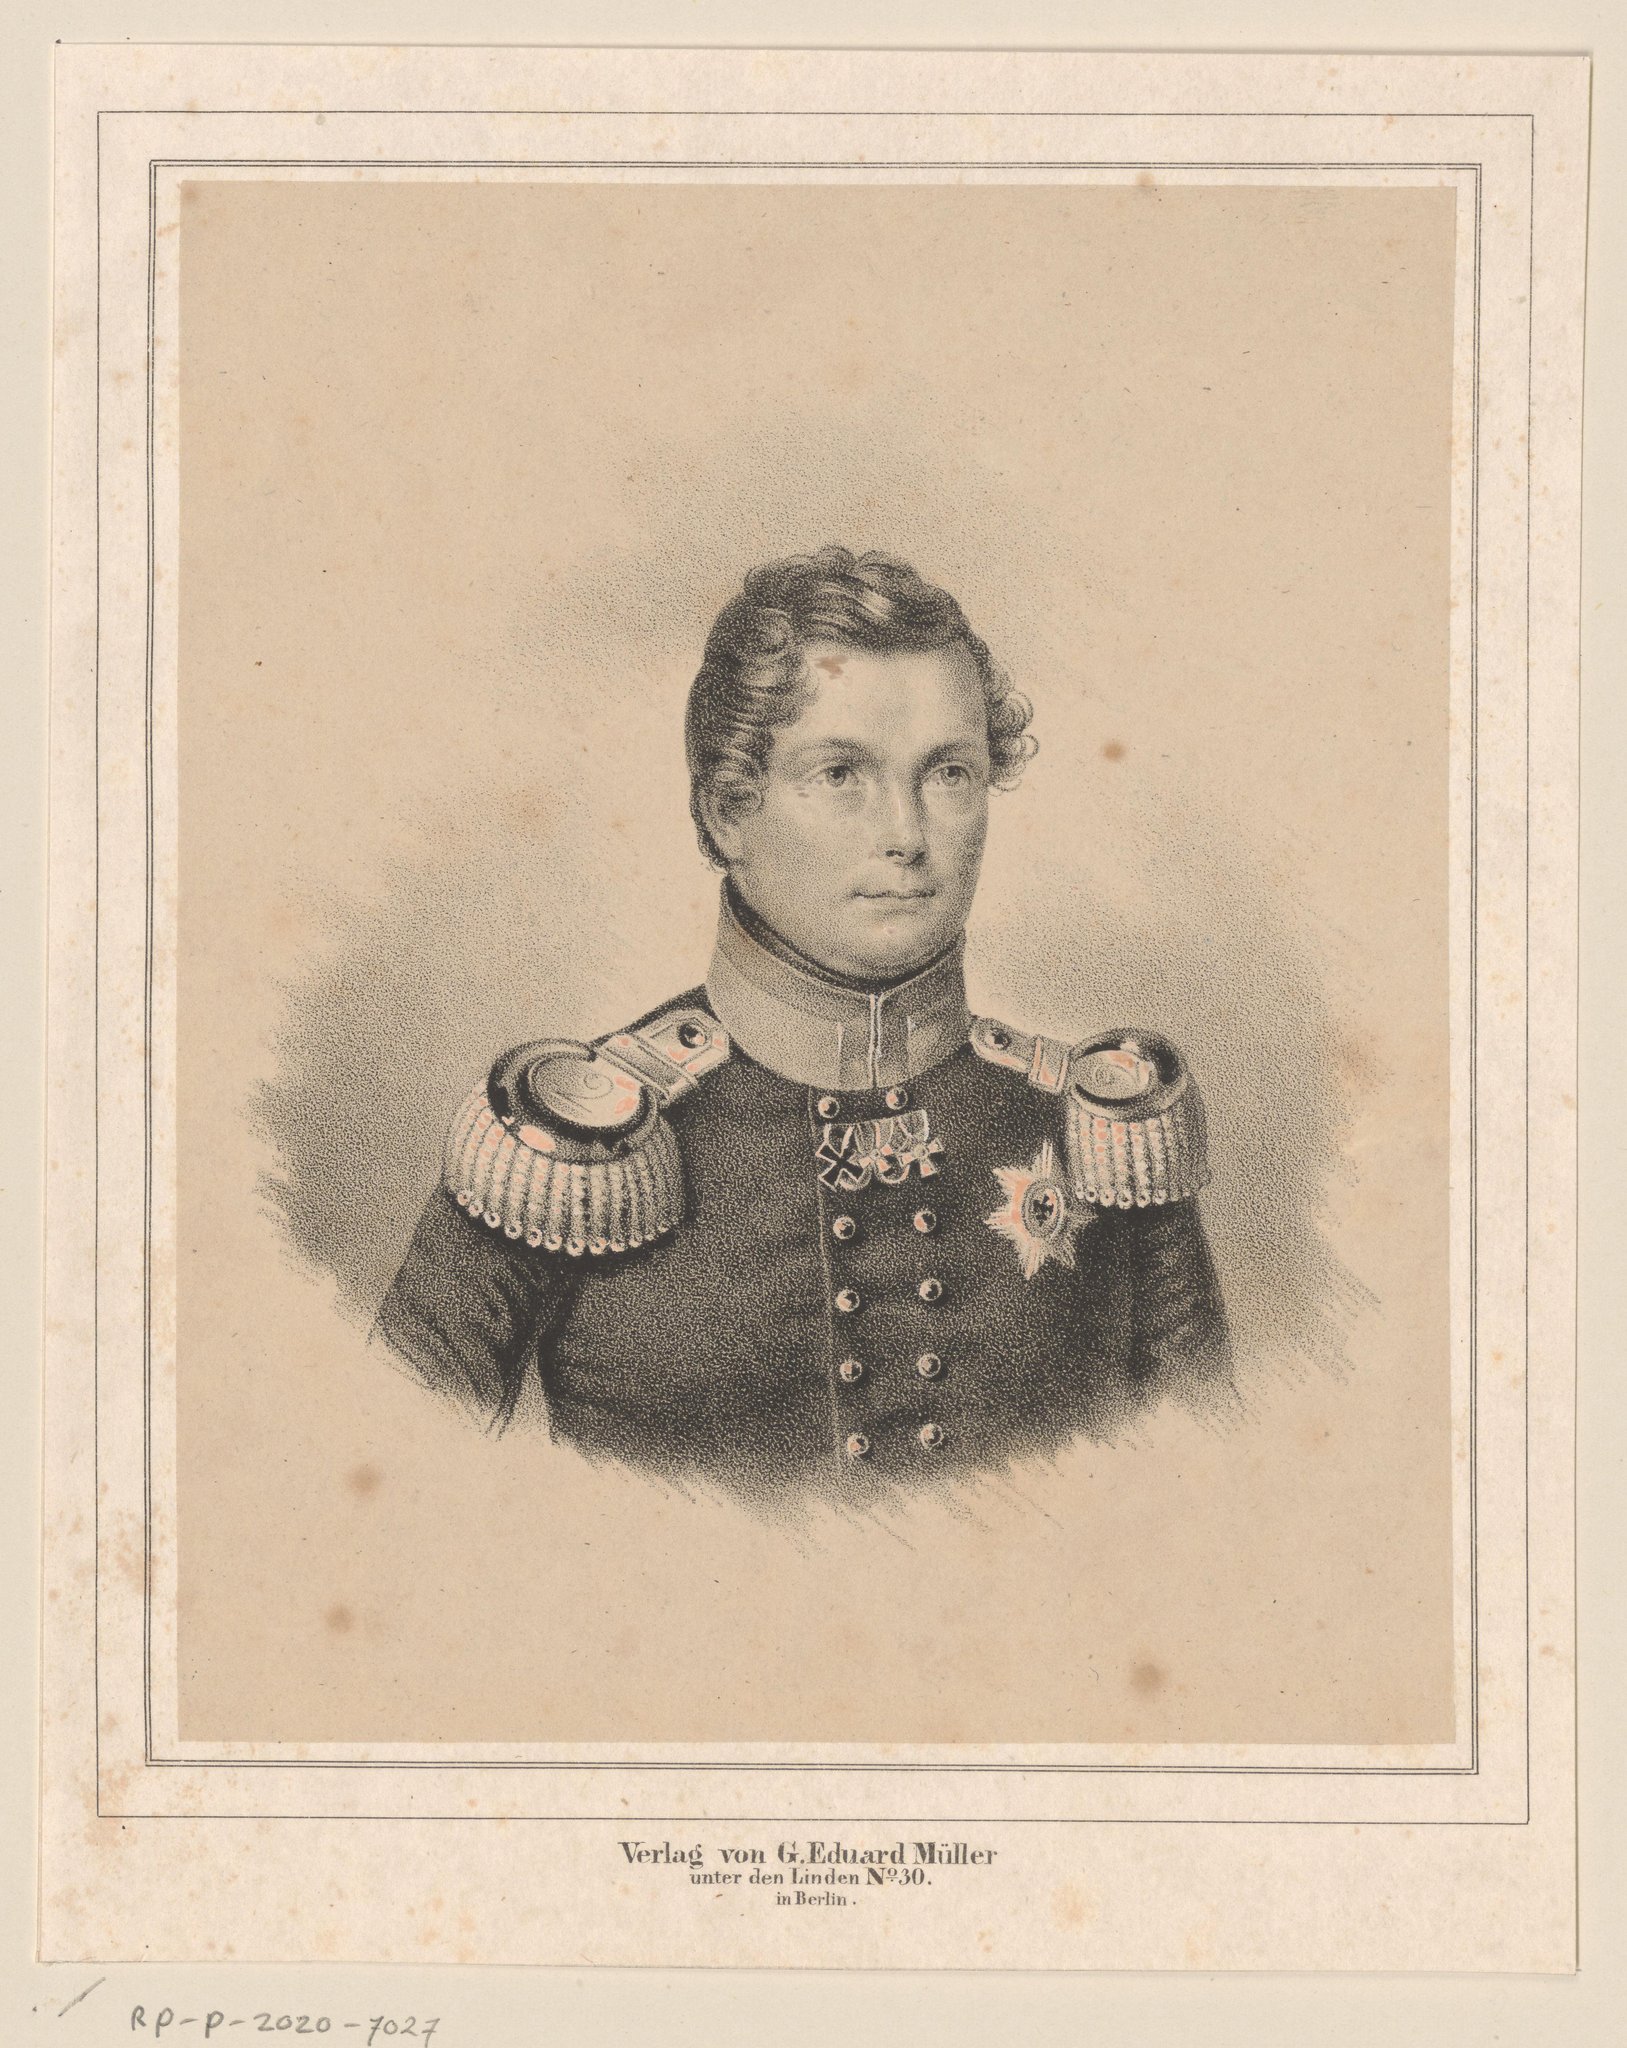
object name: print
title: Portret van Frederik Willem IV van Pruisen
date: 1815-1850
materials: paper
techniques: hand coloring, lithograph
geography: germany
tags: berlin, frederik willem iv (koning van pruisen), historical persons, (military) uniforms